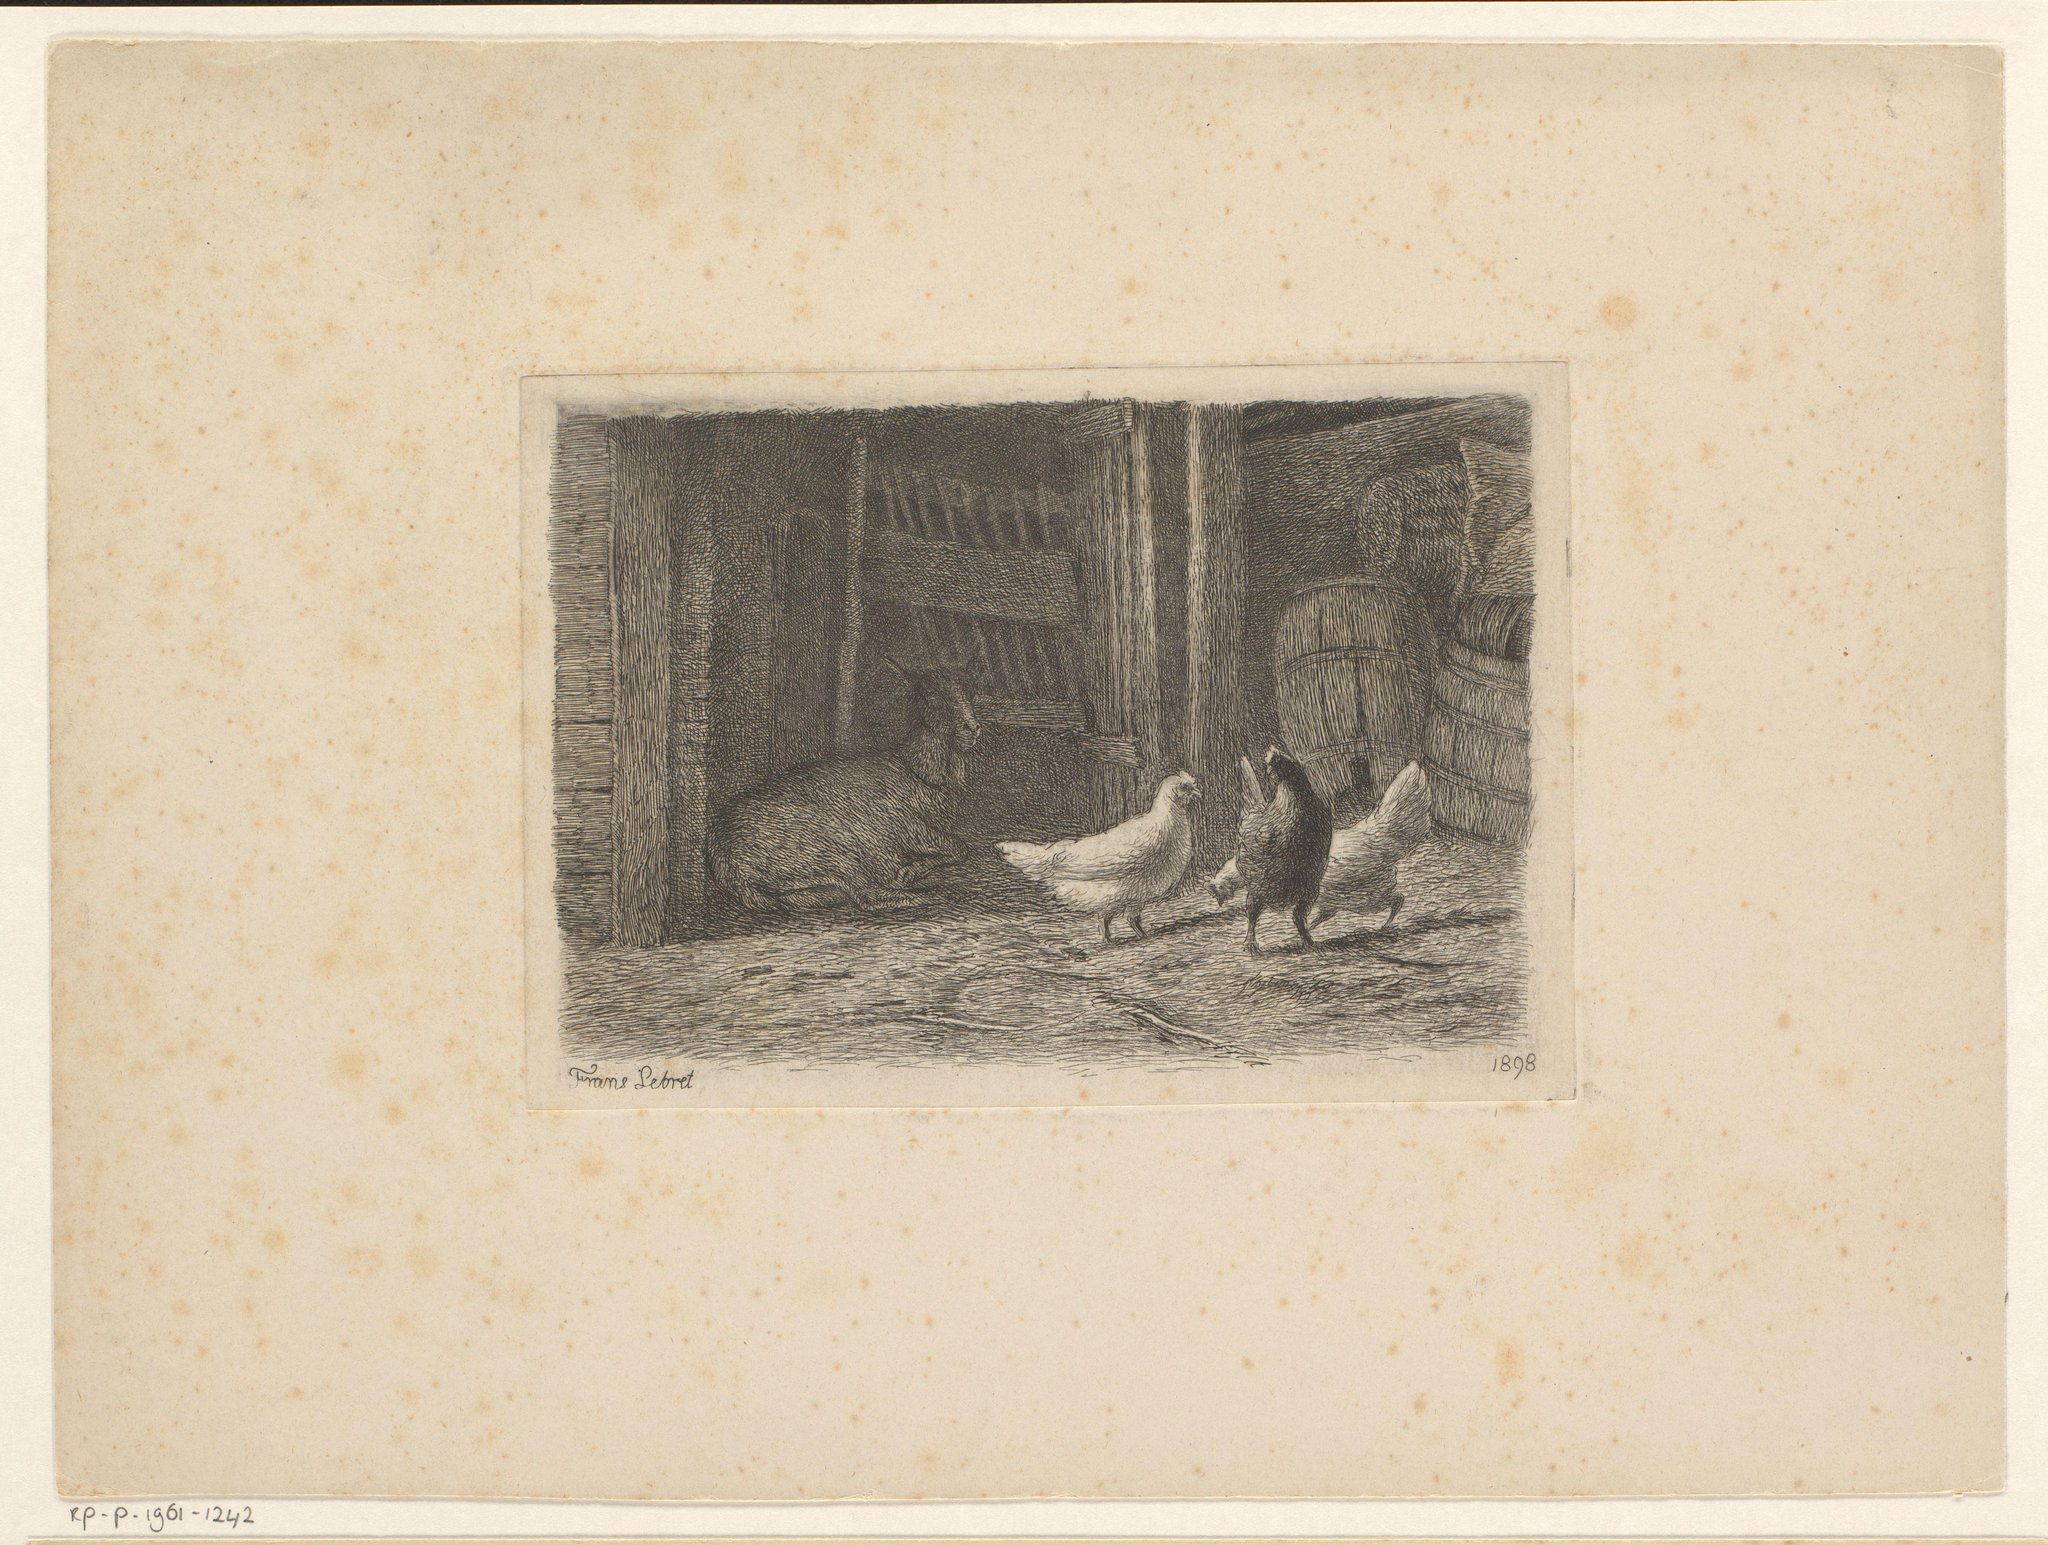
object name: print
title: Liggende geit en drie kippen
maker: frans lebret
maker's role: draughtsman, painter, print maker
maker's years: 1820-1909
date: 1898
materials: paper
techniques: etching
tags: barn, fowl (cock, hen, chicken, etc.), goat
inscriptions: collector's mark: Lugt 2228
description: Een liggende geit in een open schuur, rechts op de voorgrond lopen drie kippen.